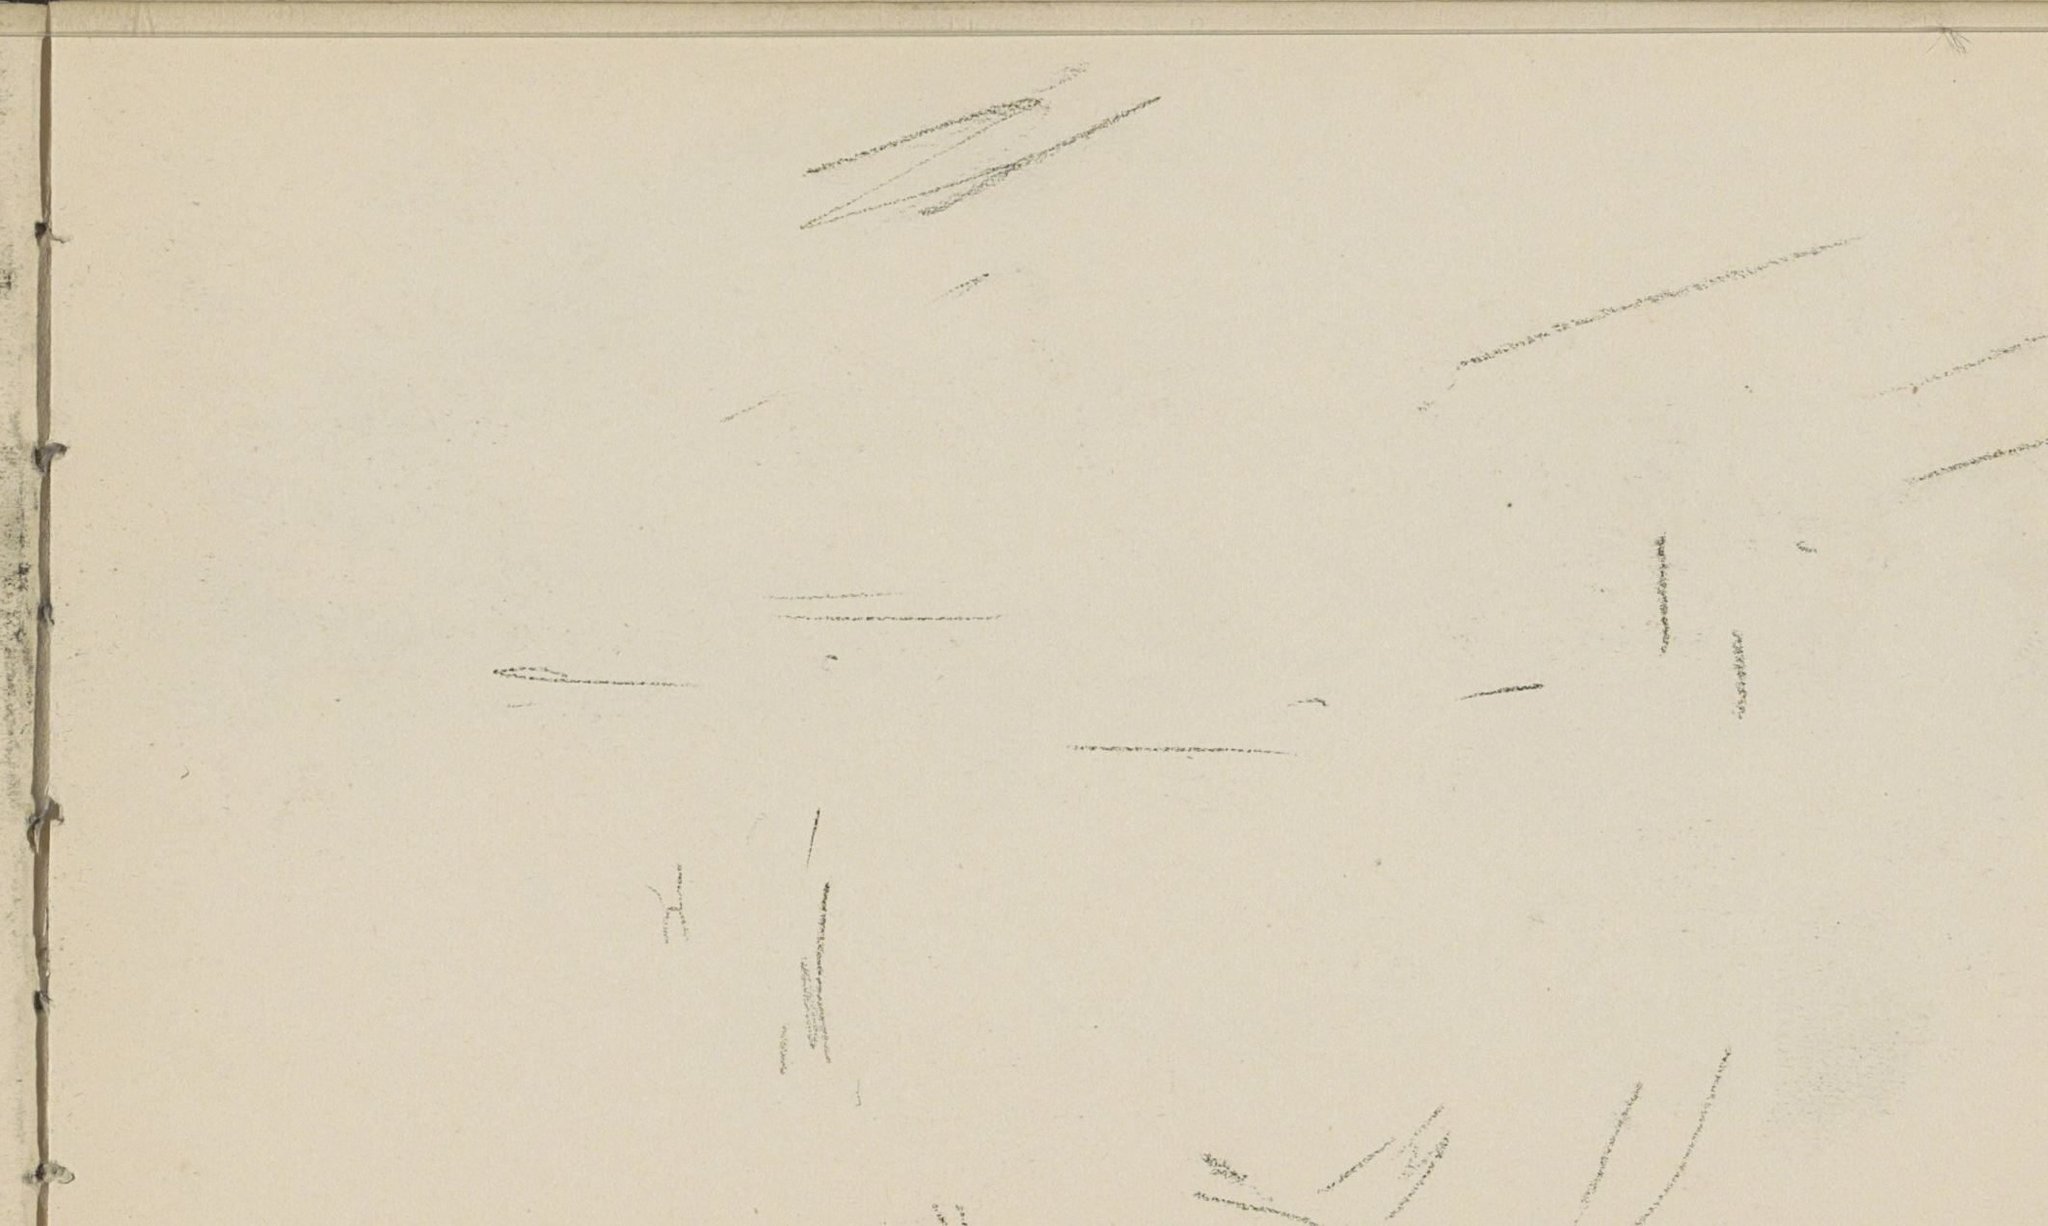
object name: sketchbook leaf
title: Studie, mogelijk een landschap met bomen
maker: johan antonie de jonge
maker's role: draughtsman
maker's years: 1864-1927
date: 1881-1927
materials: chalk, paper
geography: south holland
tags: trees, landscapes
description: Studie, mogelijk een landschap met bomen. Blad 10 recto uit een schetsboek met 34 bladen.